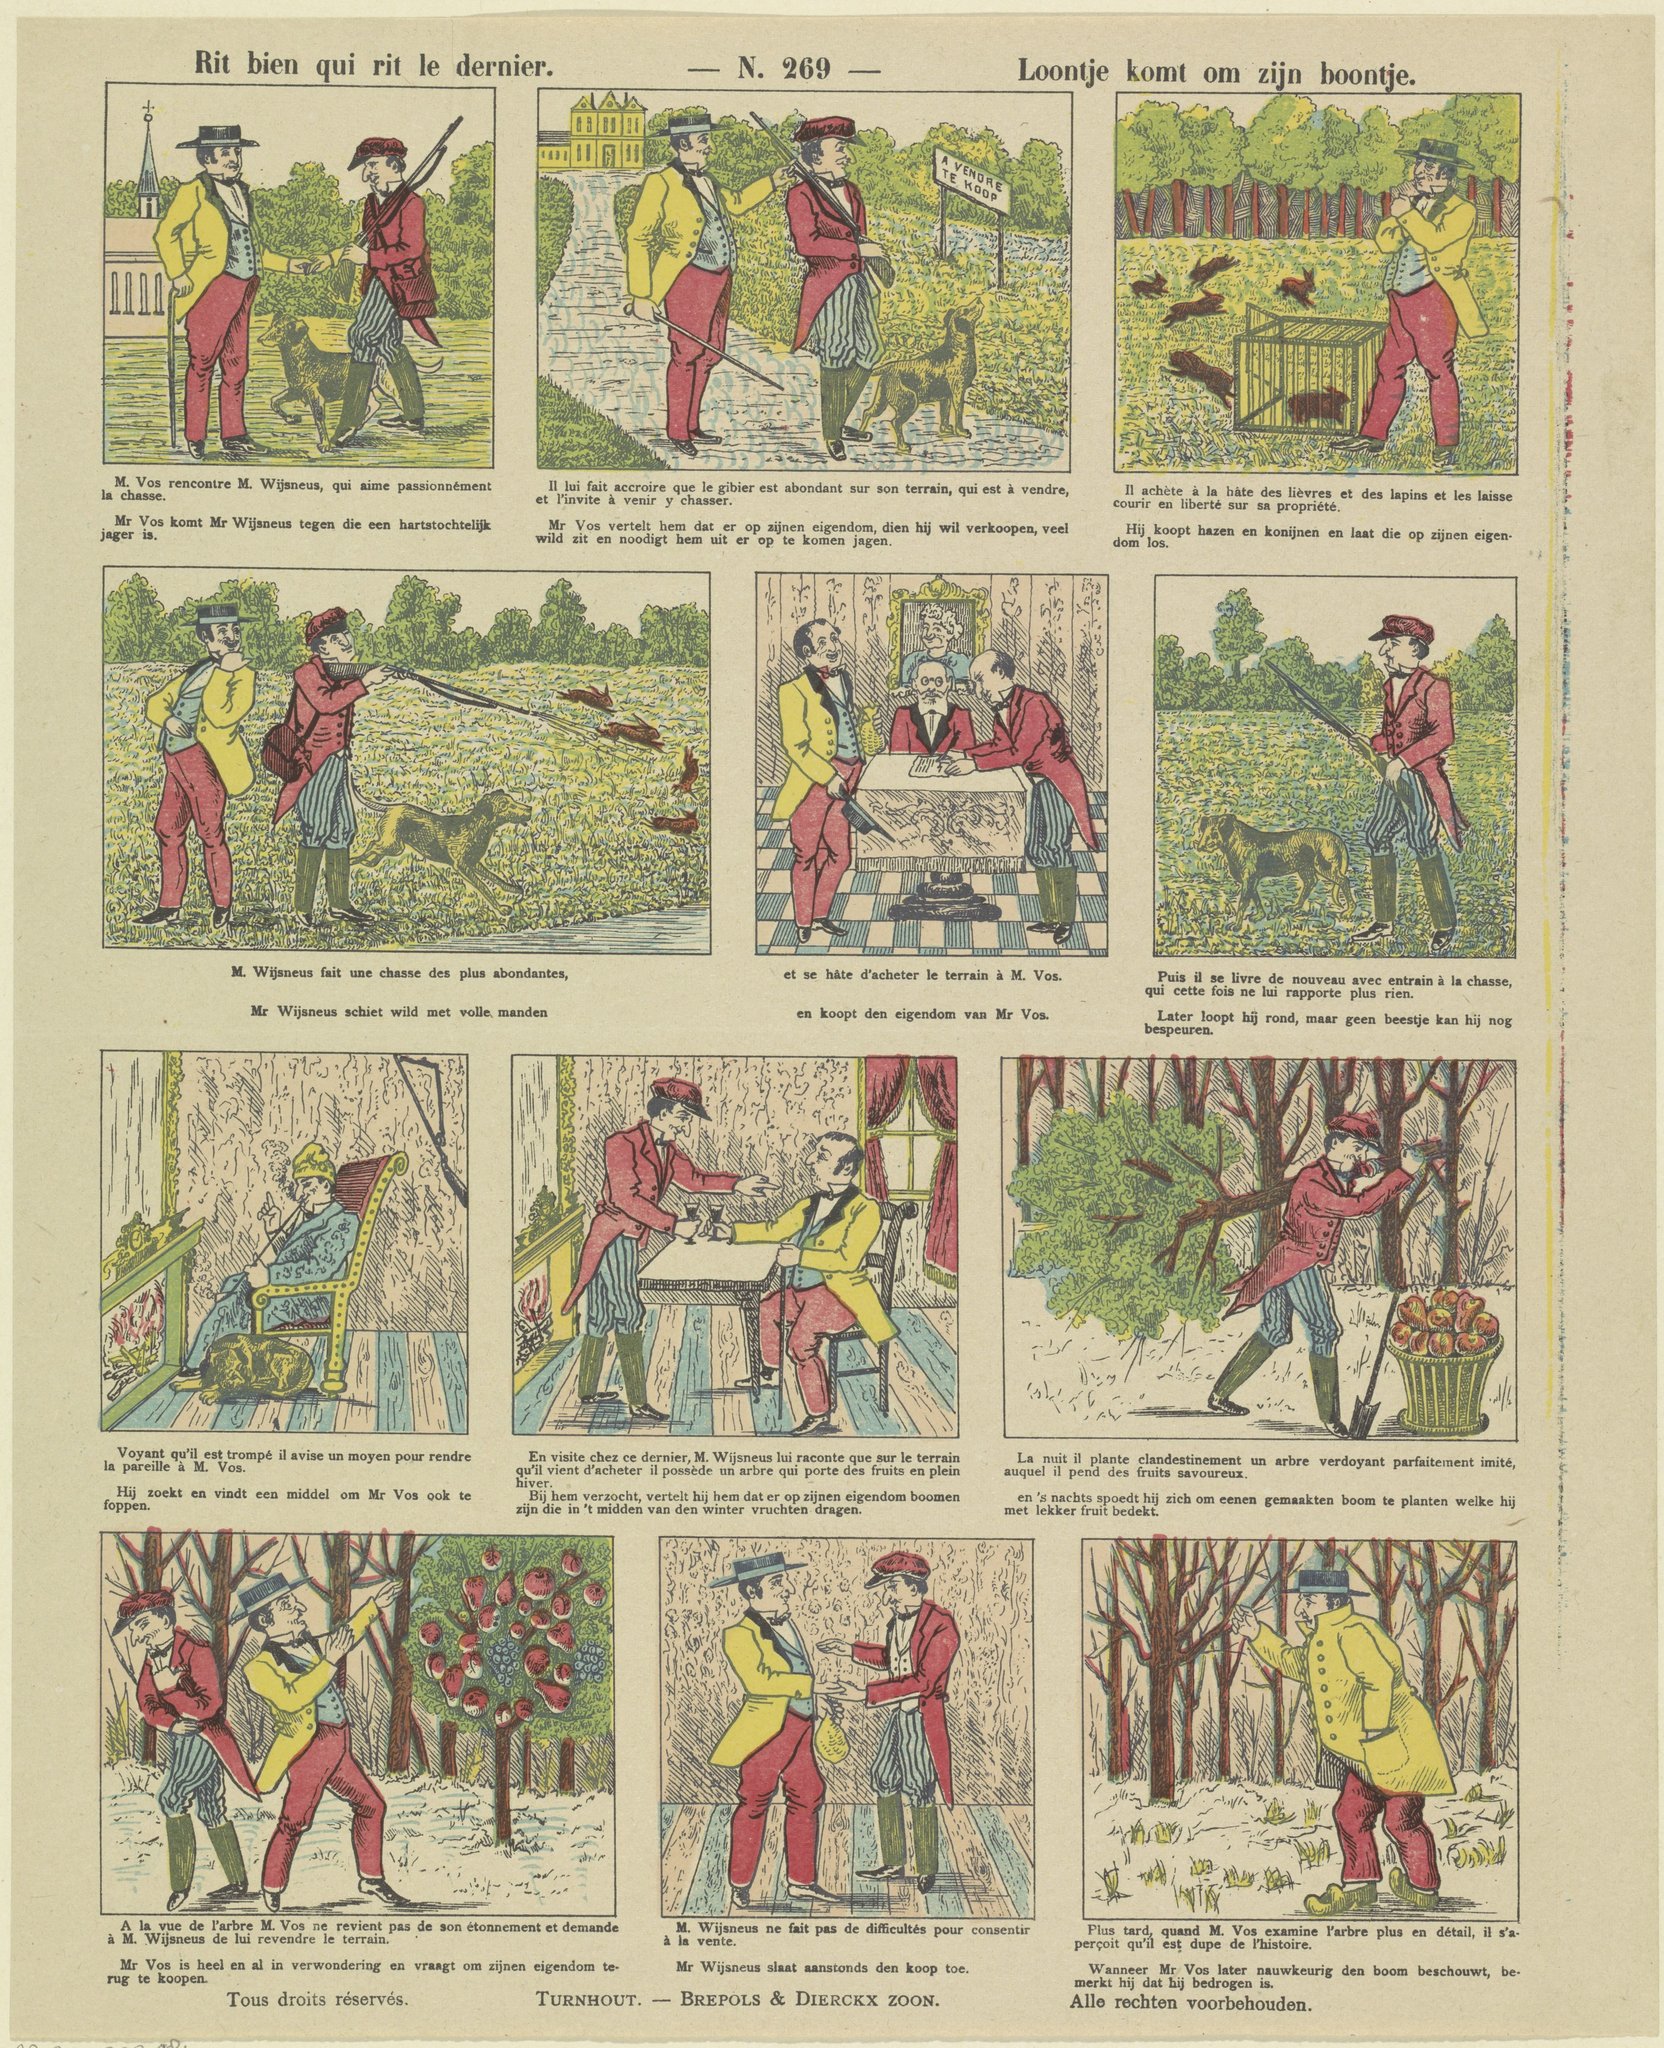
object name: print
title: Rit bien qui rit le dernier / Loontje komt om zijn boontje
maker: Anonymous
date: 1833-1911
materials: paper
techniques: lithograph, letterpress printing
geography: turnhout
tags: fruit-tree culture; fruit harvest, hunter, tales and fairy tales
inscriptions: collector's mark: Lugt 2760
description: Blad met 12 voorstellingen over twee mannen, Mr. Vos en Mr. Wijsneus, die elkaar voor de gek houden. Onder elke afbeelding een onderschrift in het Nederlands en in het Frans. Genummerd midden boven: N. 269.